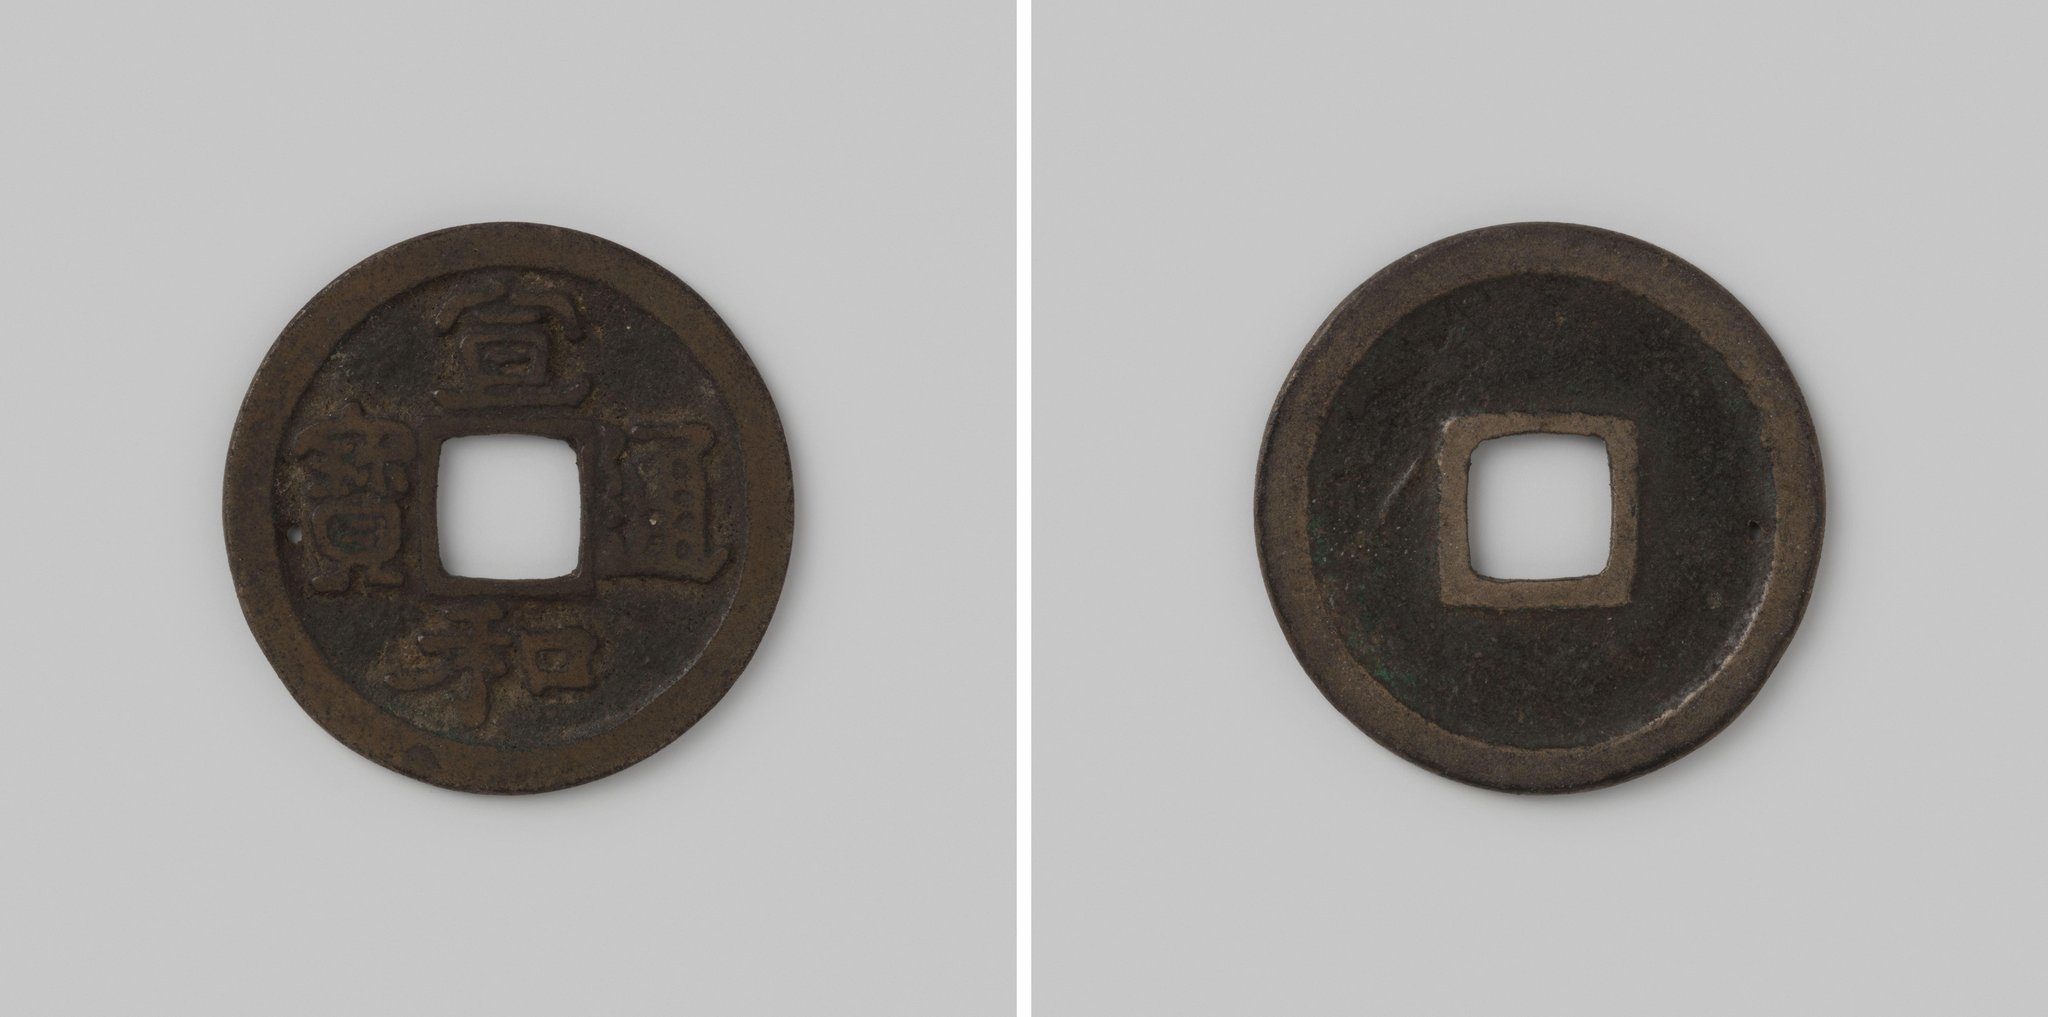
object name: coin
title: Cash van het keizerrijk China van keizer Jen Tsung onder de regeringsnaam Chia-Ch ing,1796 -1820 uit Yun in Yunnan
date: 1796-1820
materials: copper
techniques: casting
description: Koperen munt. Voorzijde: binnen brede opstaande rand rondom vierkante uitsparing in het midden vier kruisgewijze geplaatste Chinese tekens, waarvan twee met de betekenis: Chia ch ing. Keerzijde: binnen brede opstaande rand ter weerszijden van vierkante uitsparing in het midden twee Chinese tekens, waarbij het rechter teken met de betekenis: Yun in de provincie Yunnan.